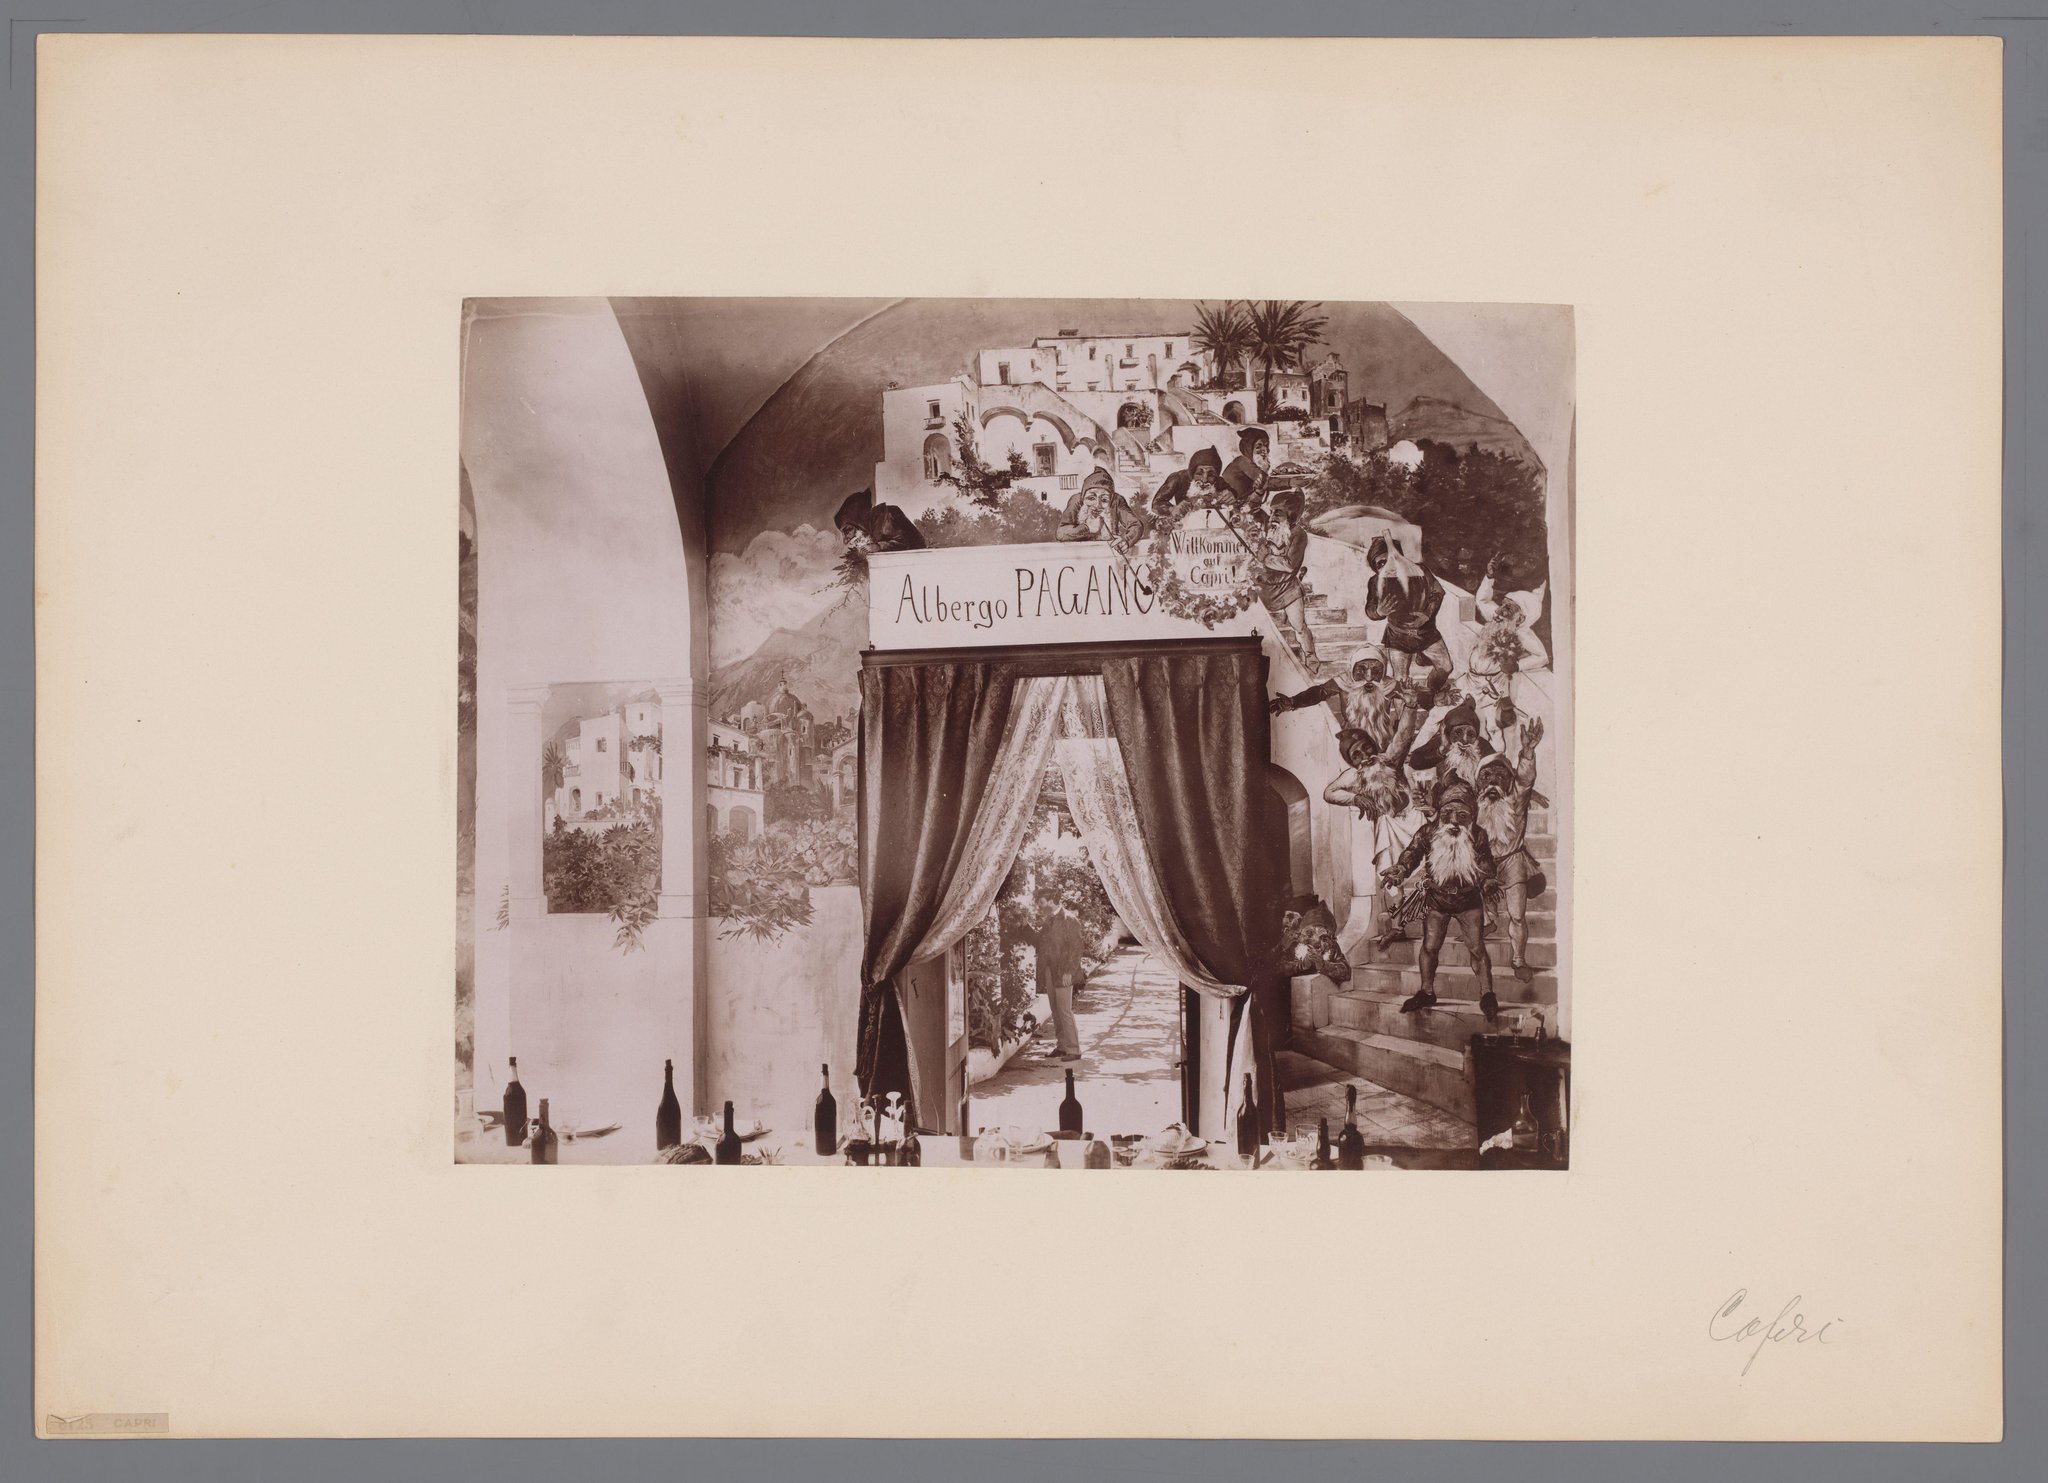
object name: photograph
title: Capri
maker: giorgio sommer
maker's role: fotograaf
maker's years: 1834-1914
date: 1857-1914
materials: cardboard, paper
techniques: albumen print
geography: capri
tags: hotel, hostelry, inn, capri, isola di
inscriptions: number: ‘6125’, inscription: ‘Capri’